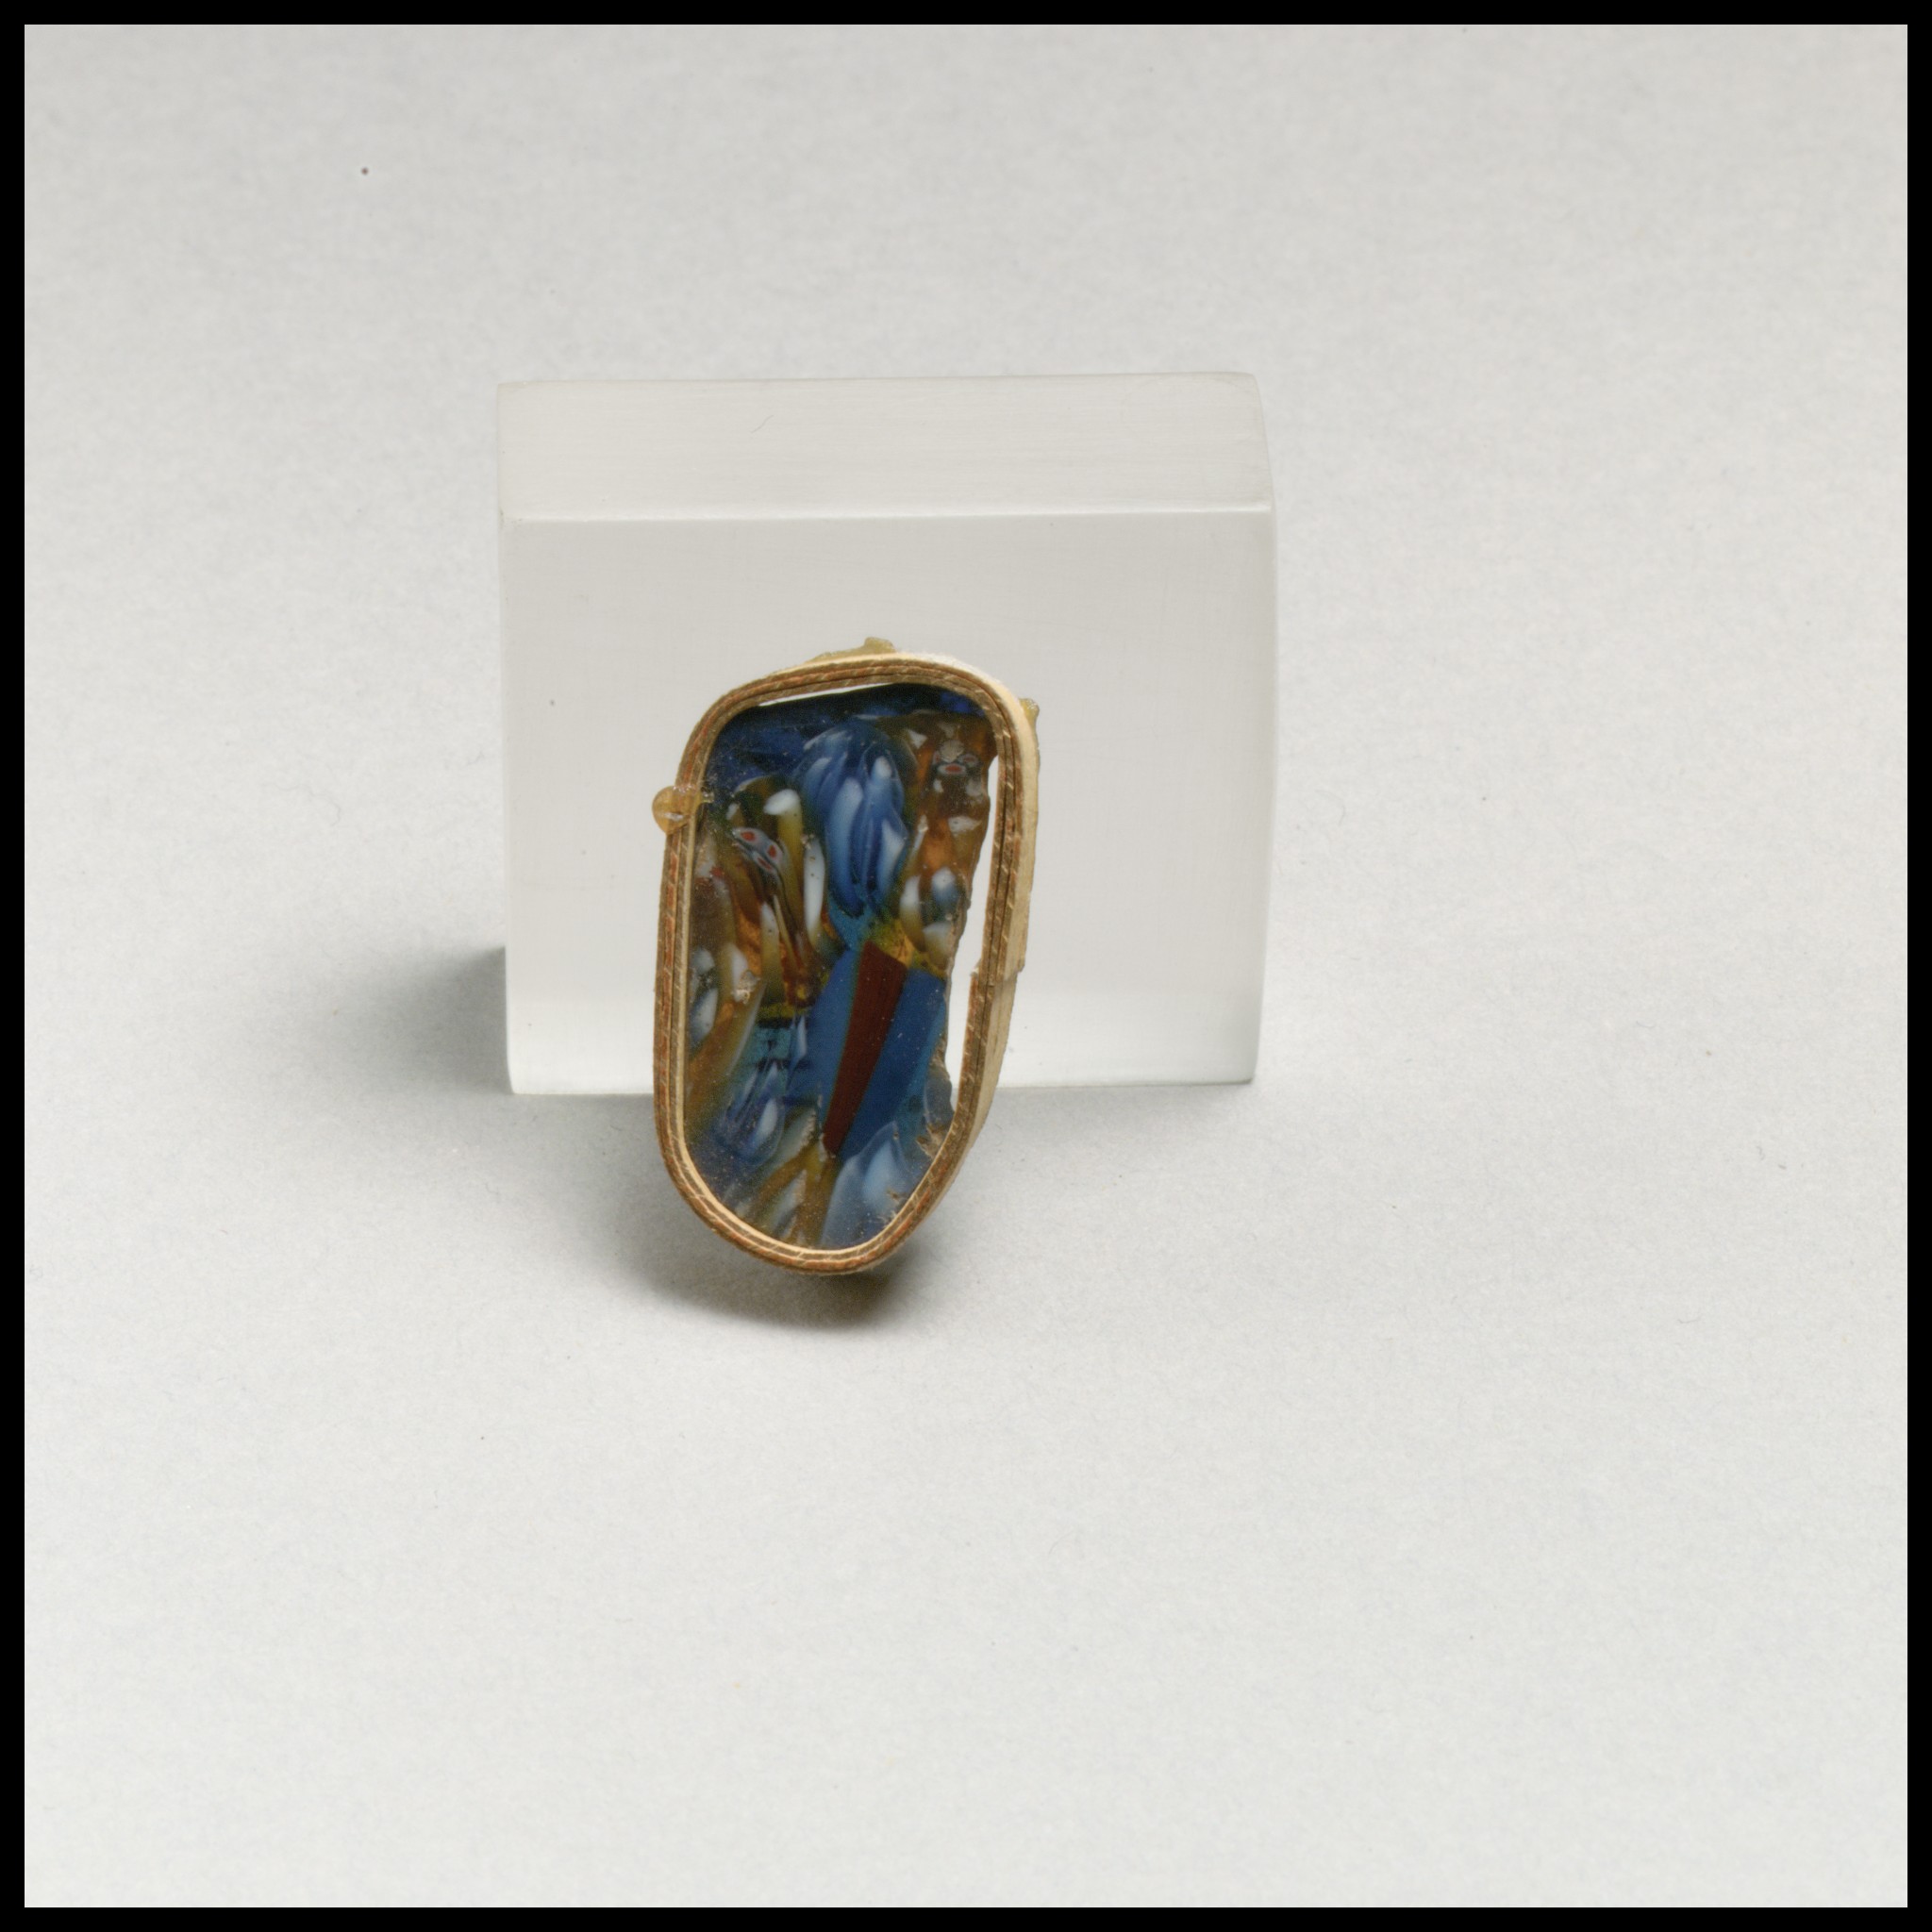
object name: fragment, mosaic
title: Glass mosaic bowl fragment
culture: roman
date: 34 BCE-33 CE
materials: glass